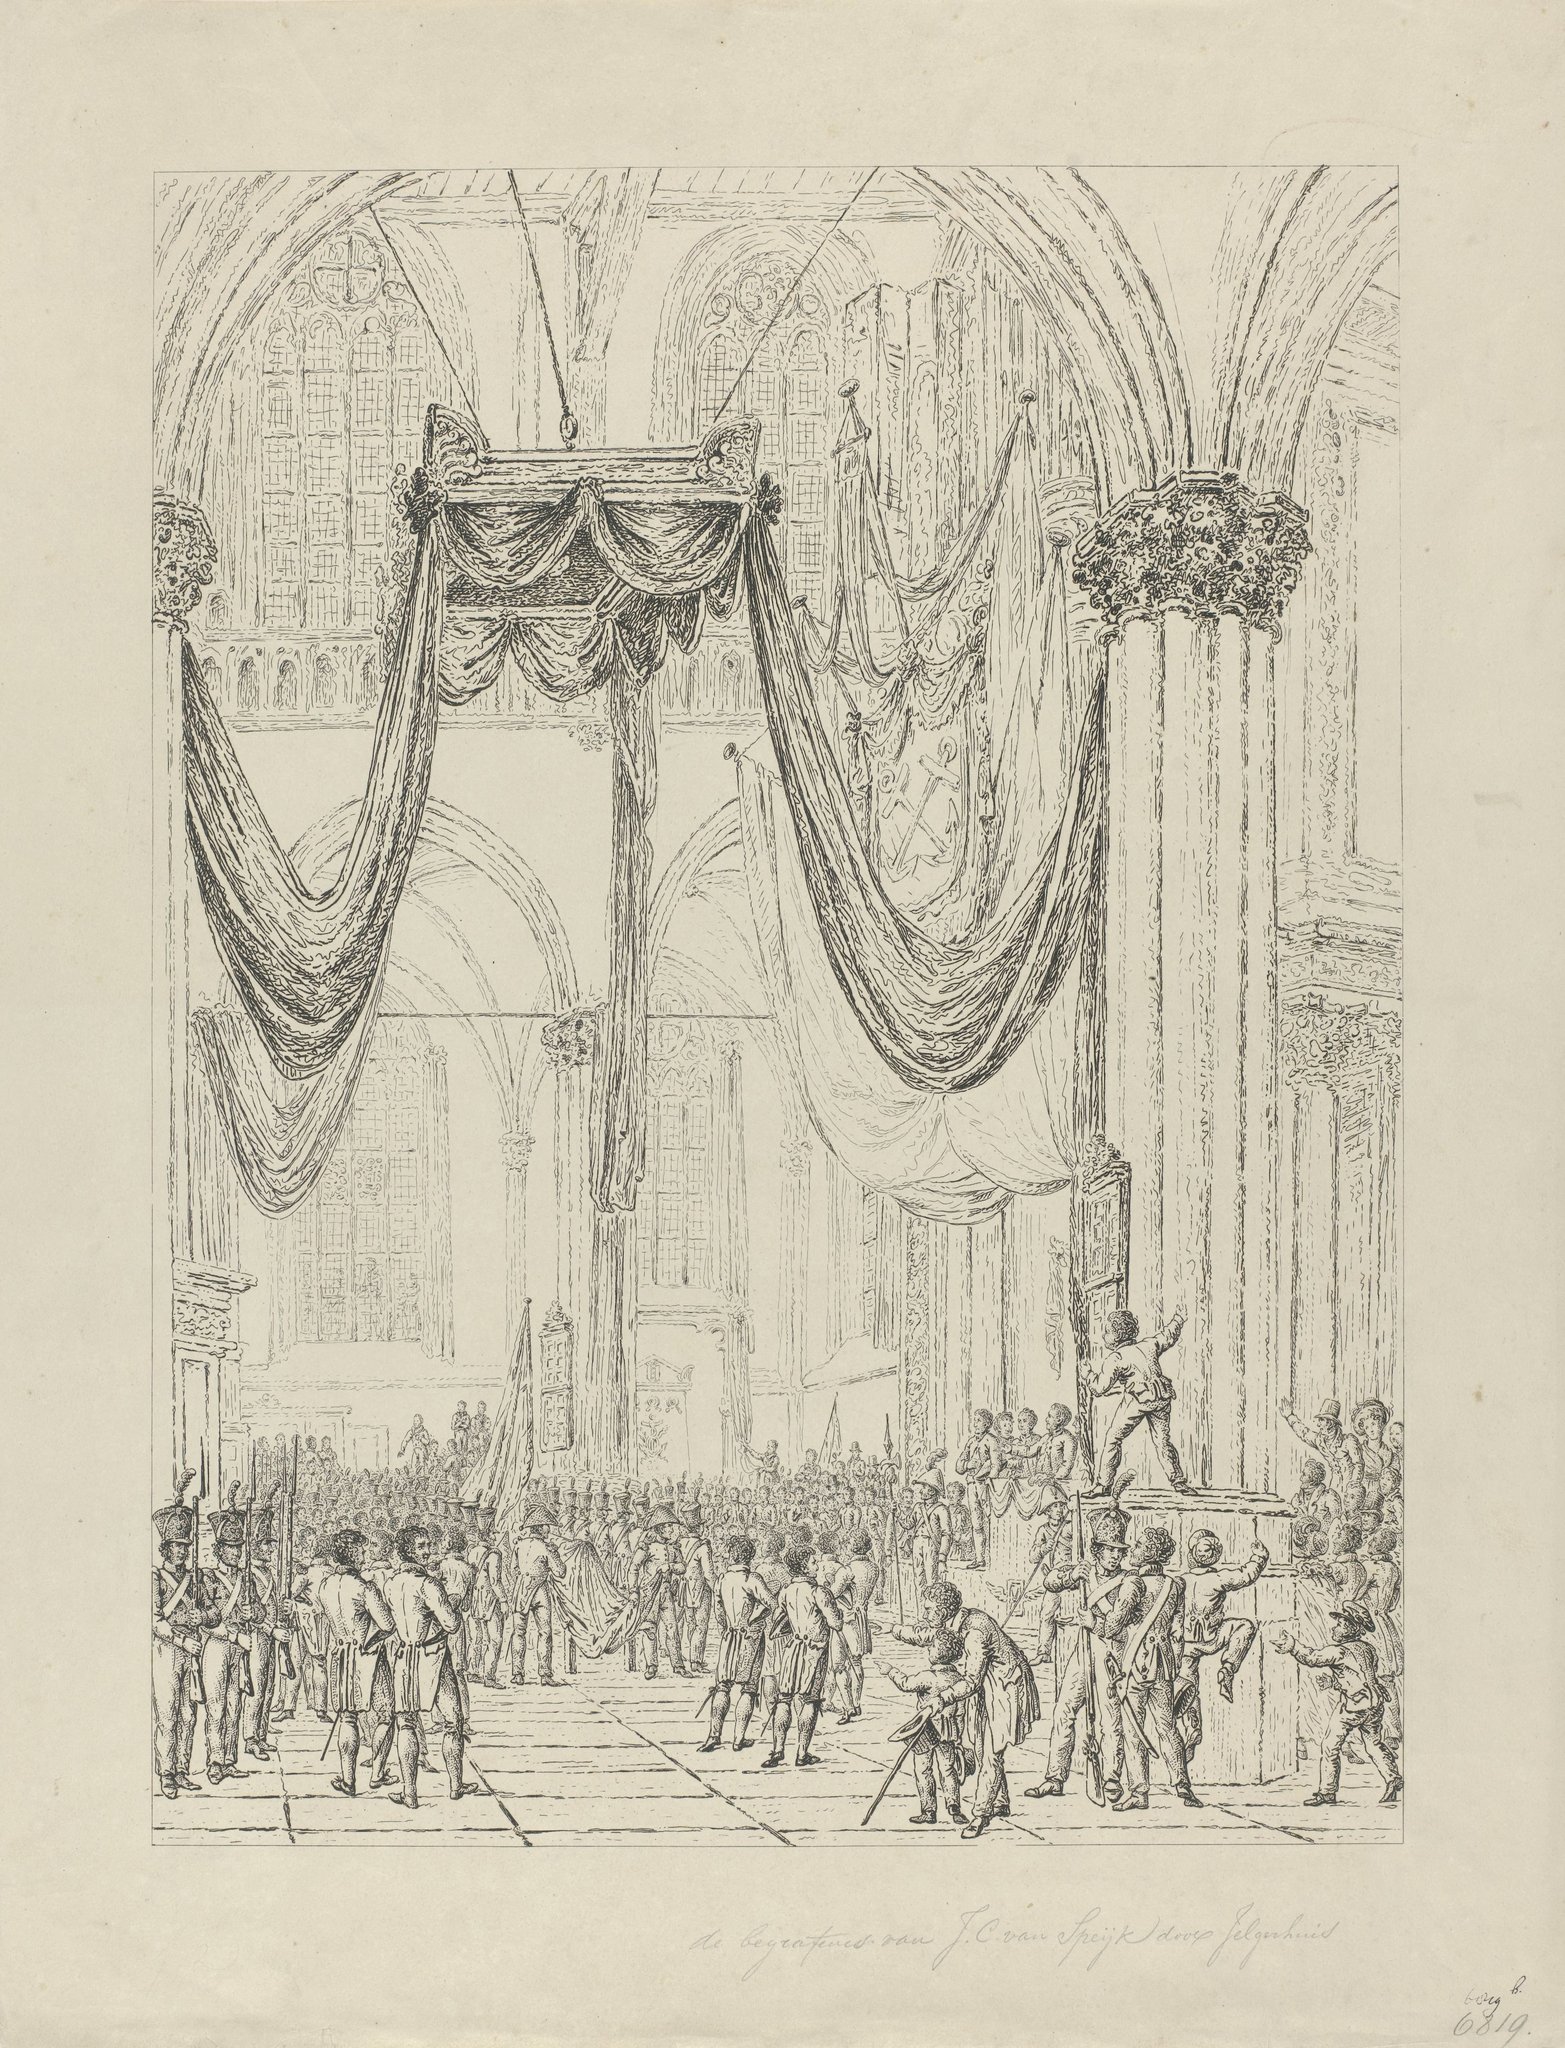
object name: print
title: Begrafenis van Jan van Speyk, 1832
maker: johannes jelgerhuis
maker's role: draughtsman, painter, print maker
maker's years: 1770-1836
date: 1832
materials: paper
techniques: etching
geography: netherlands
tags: amsterdam, antwerp, jan van speyk, address at open grave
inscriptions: inscription: ‘coll. Franken’, collector's mark: Lugt 2228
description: De begrafenis van de stoffelijke resten van Jan van Speyk en onthulling van het grafmonument in de Nieuwe Kerk te Amsterdam, 4 mei 1832. Een man spreekt de aanwezigen toe vanaf een verhoging. Vanaf de gewelven van de kerk zijn grote doeken gedrapeerd.